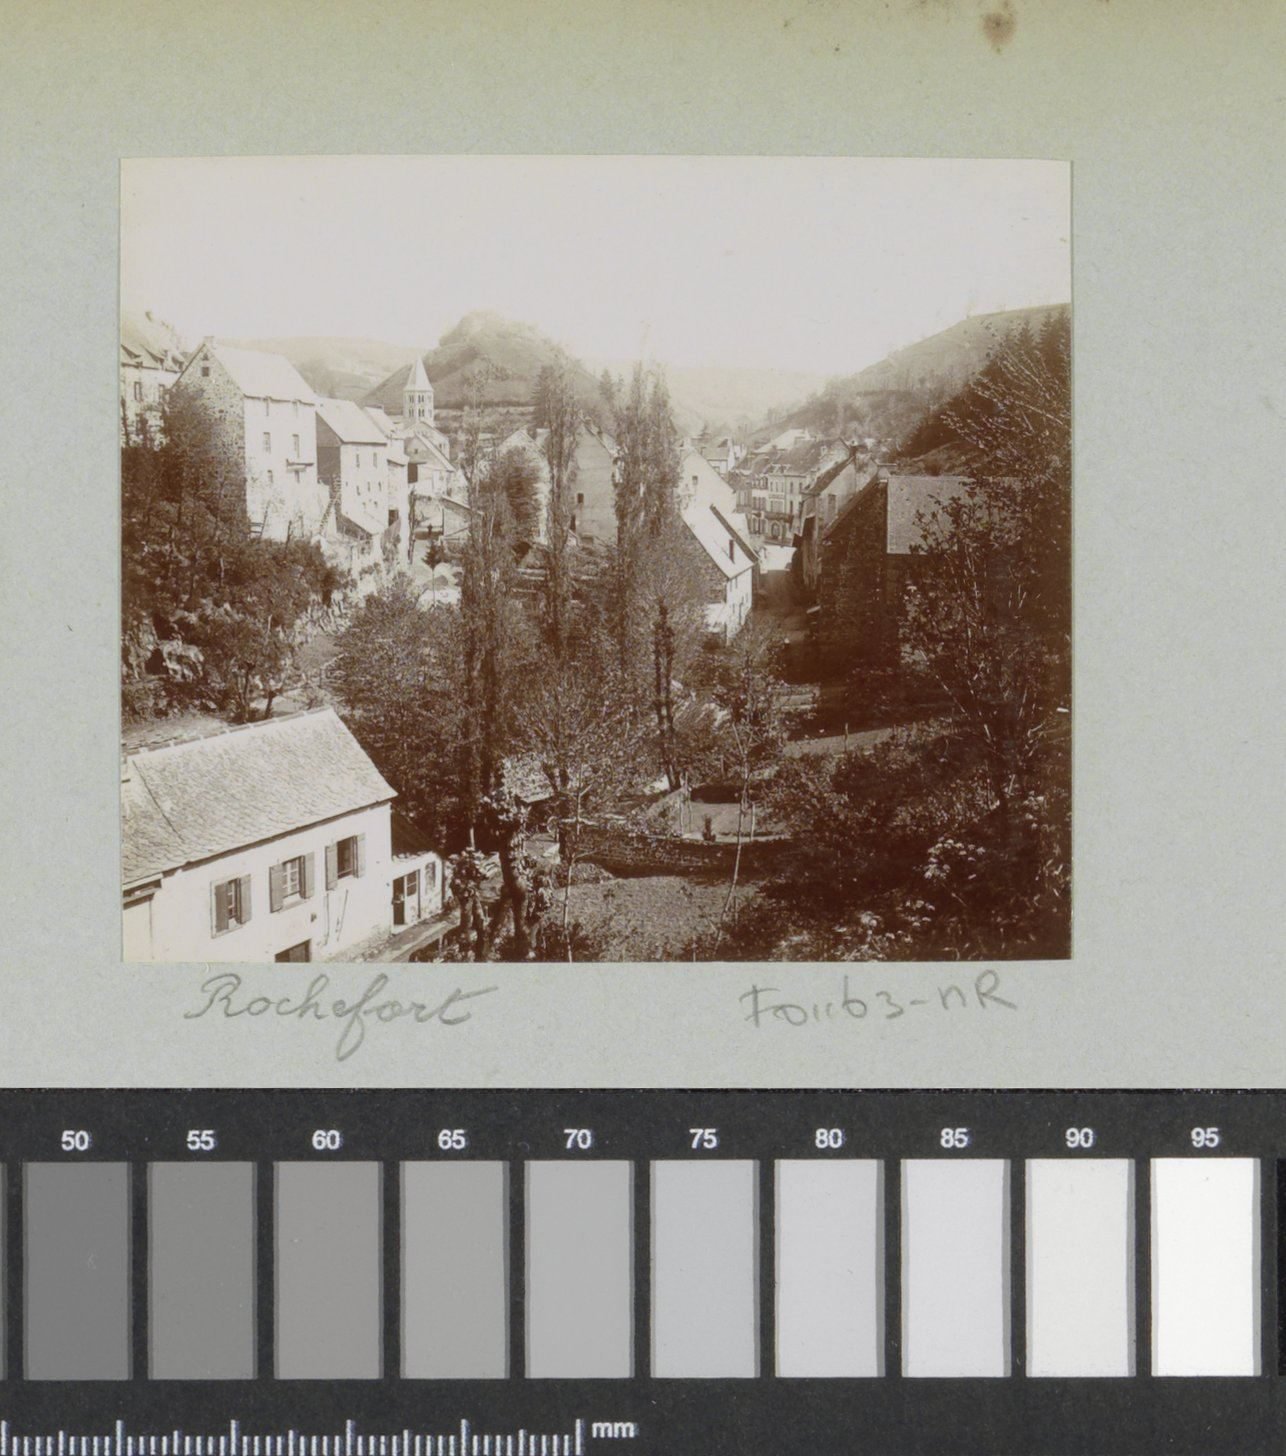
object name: photograph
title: Gezicht op Rochefort-Montagne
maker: delizy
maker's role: manufacturer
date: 1902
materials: paper, photographic support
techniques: gelatin silver print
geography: rochefort-montagne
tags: prospect of village, silhouette of village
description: Onderdeel van Fotoalbum van een Franse amateurfotograaf met opnames van uitstapjes in Frankrijk, Spanje, België, Luxemburg en Nederland, de eerste automobielen en autoraces.